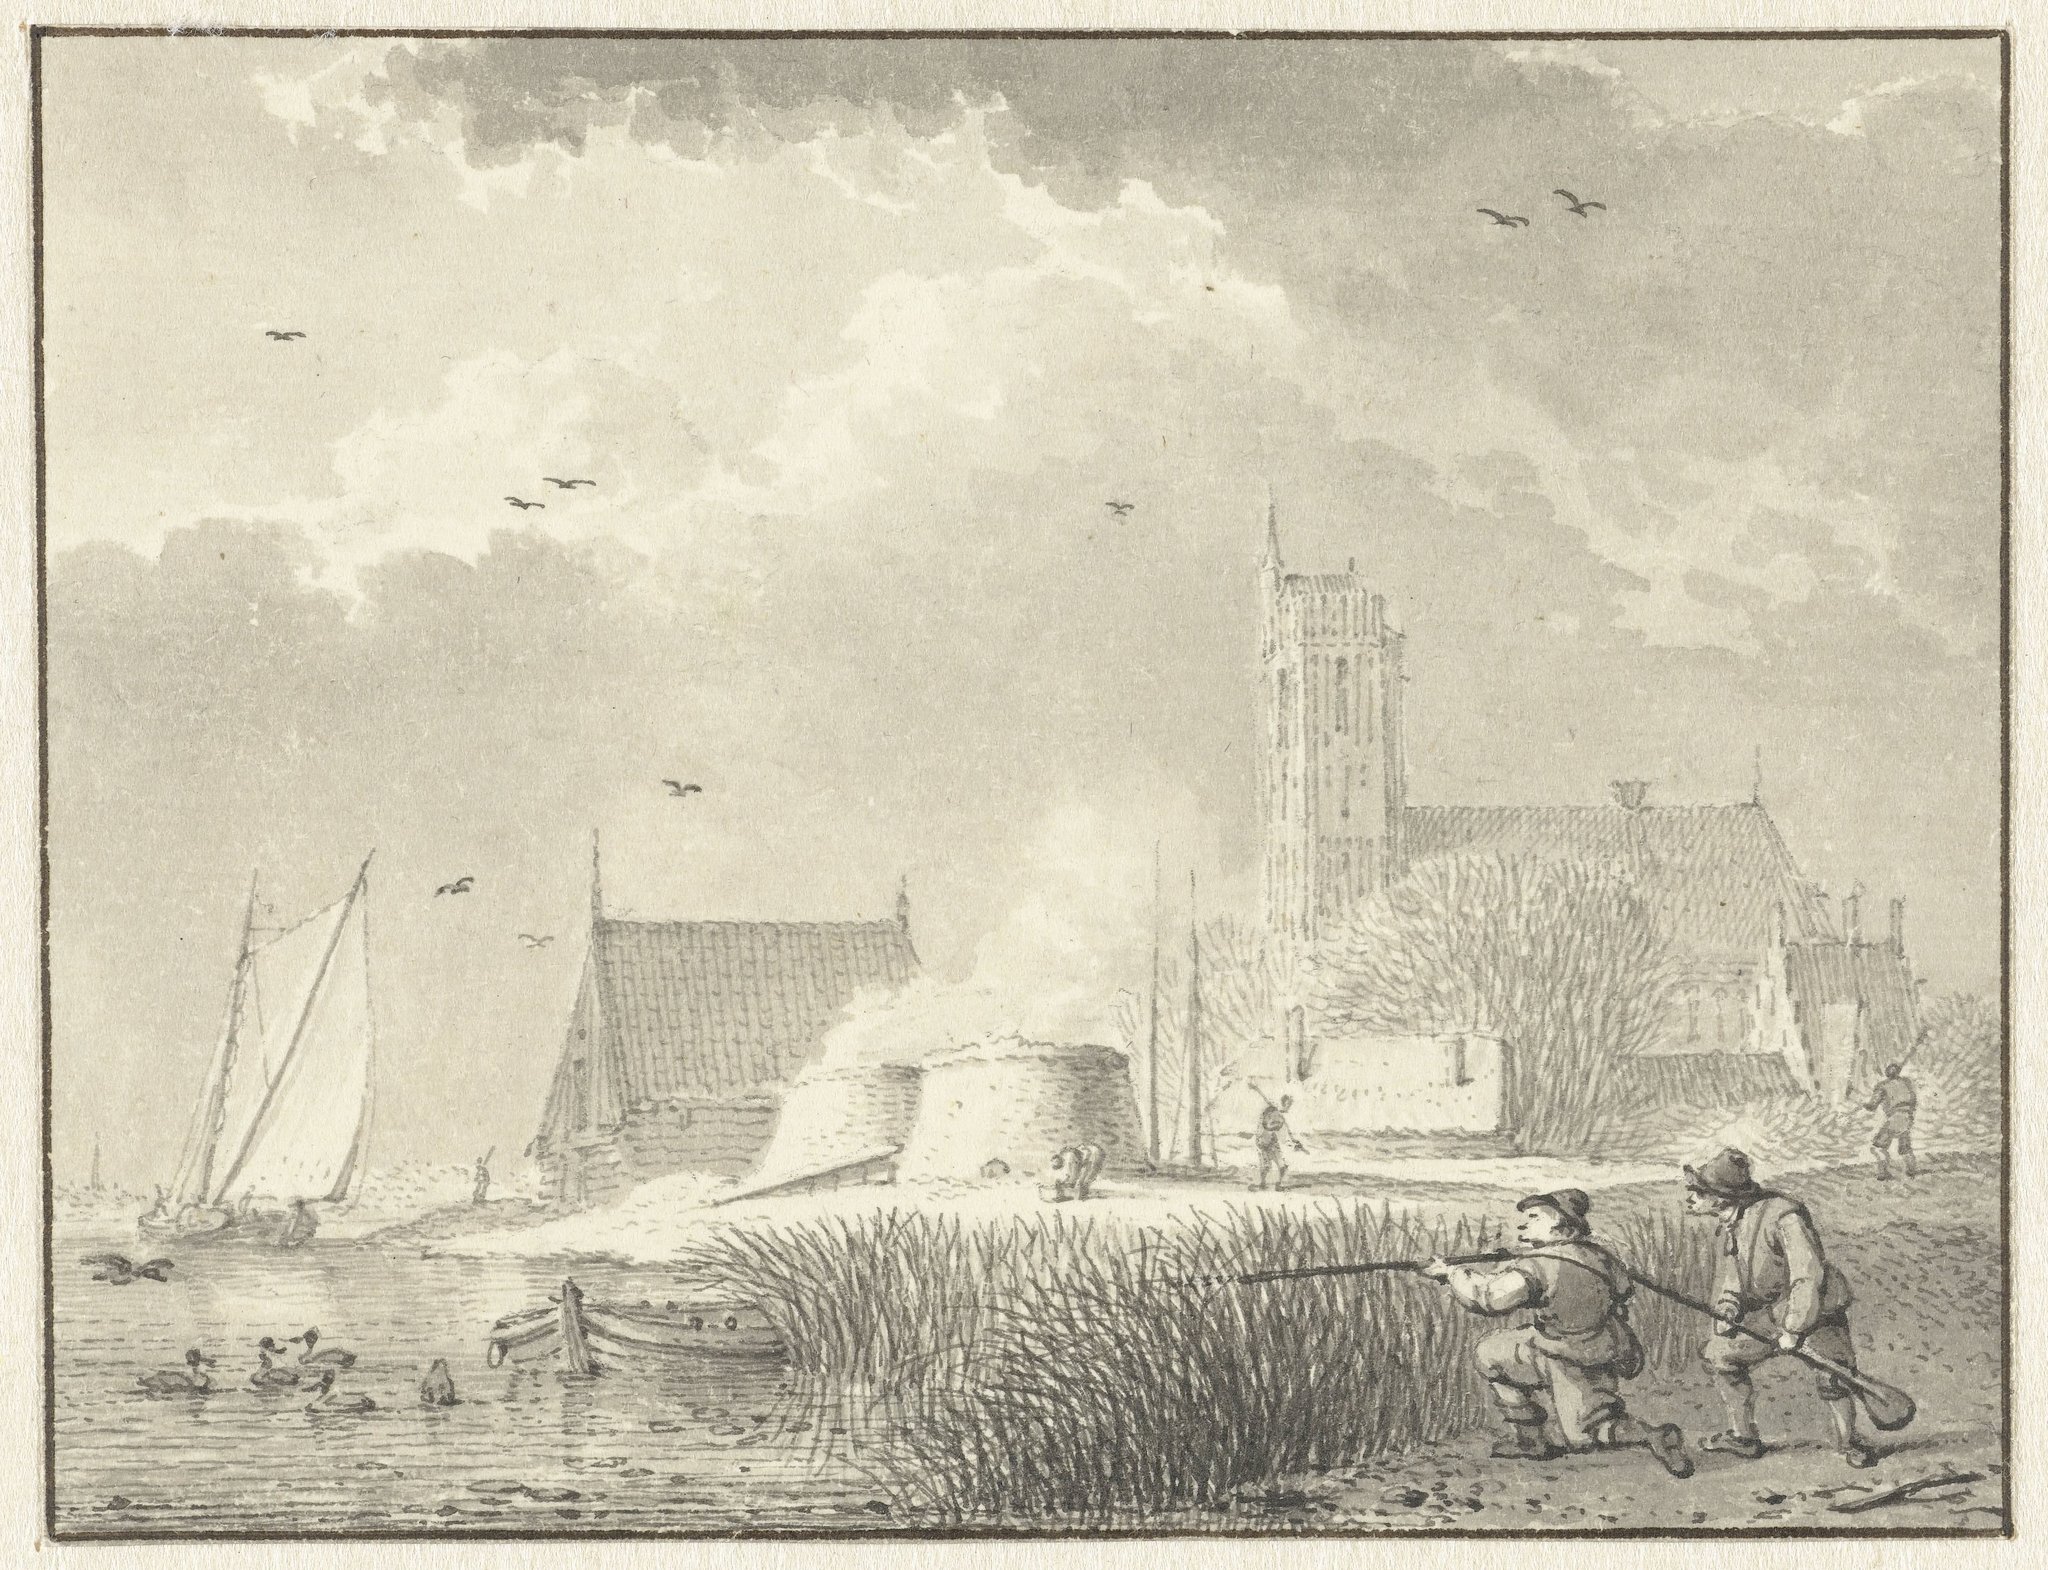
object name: drawing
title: Eendenjacht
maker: hendrik meijer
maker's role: draughtsman, print maker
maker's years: 1744-1793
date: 1784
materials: ink, paper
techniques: brush, pen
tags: hunting, chase